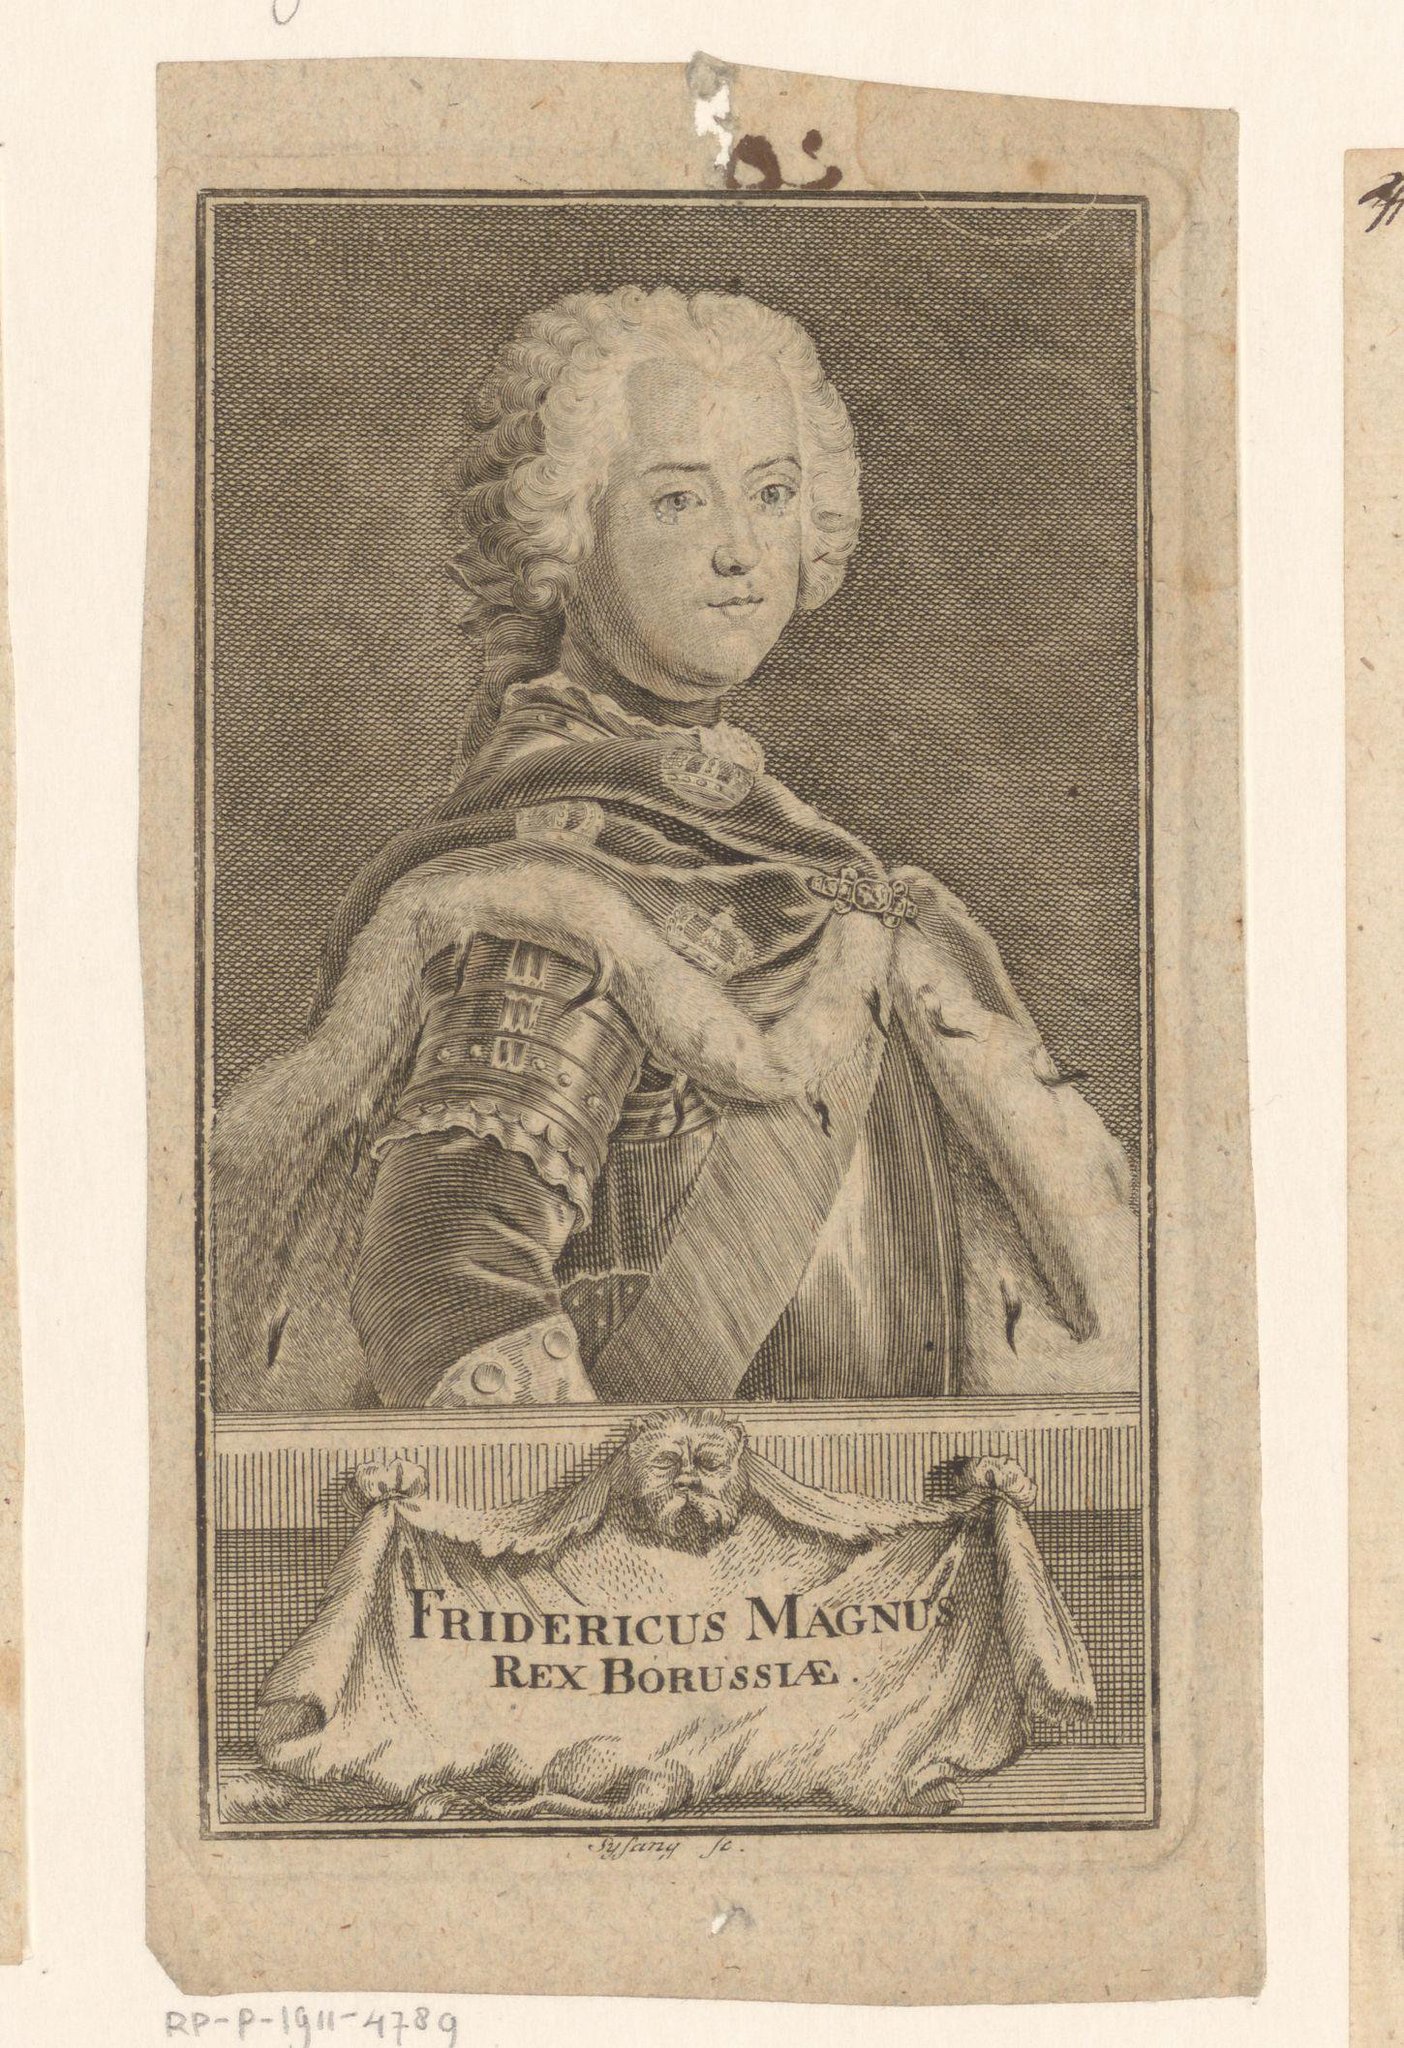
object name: print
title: Portret van Frederik de Grote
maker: johann christoph sysang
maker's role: print maker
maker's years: 1703-1757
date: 1740-1757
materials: paper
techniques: engraving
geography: leipzig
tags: berlin, frederick ii (king of prussia), historical persons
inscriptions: number: ‘29’, collector's mark: Lugt 2228